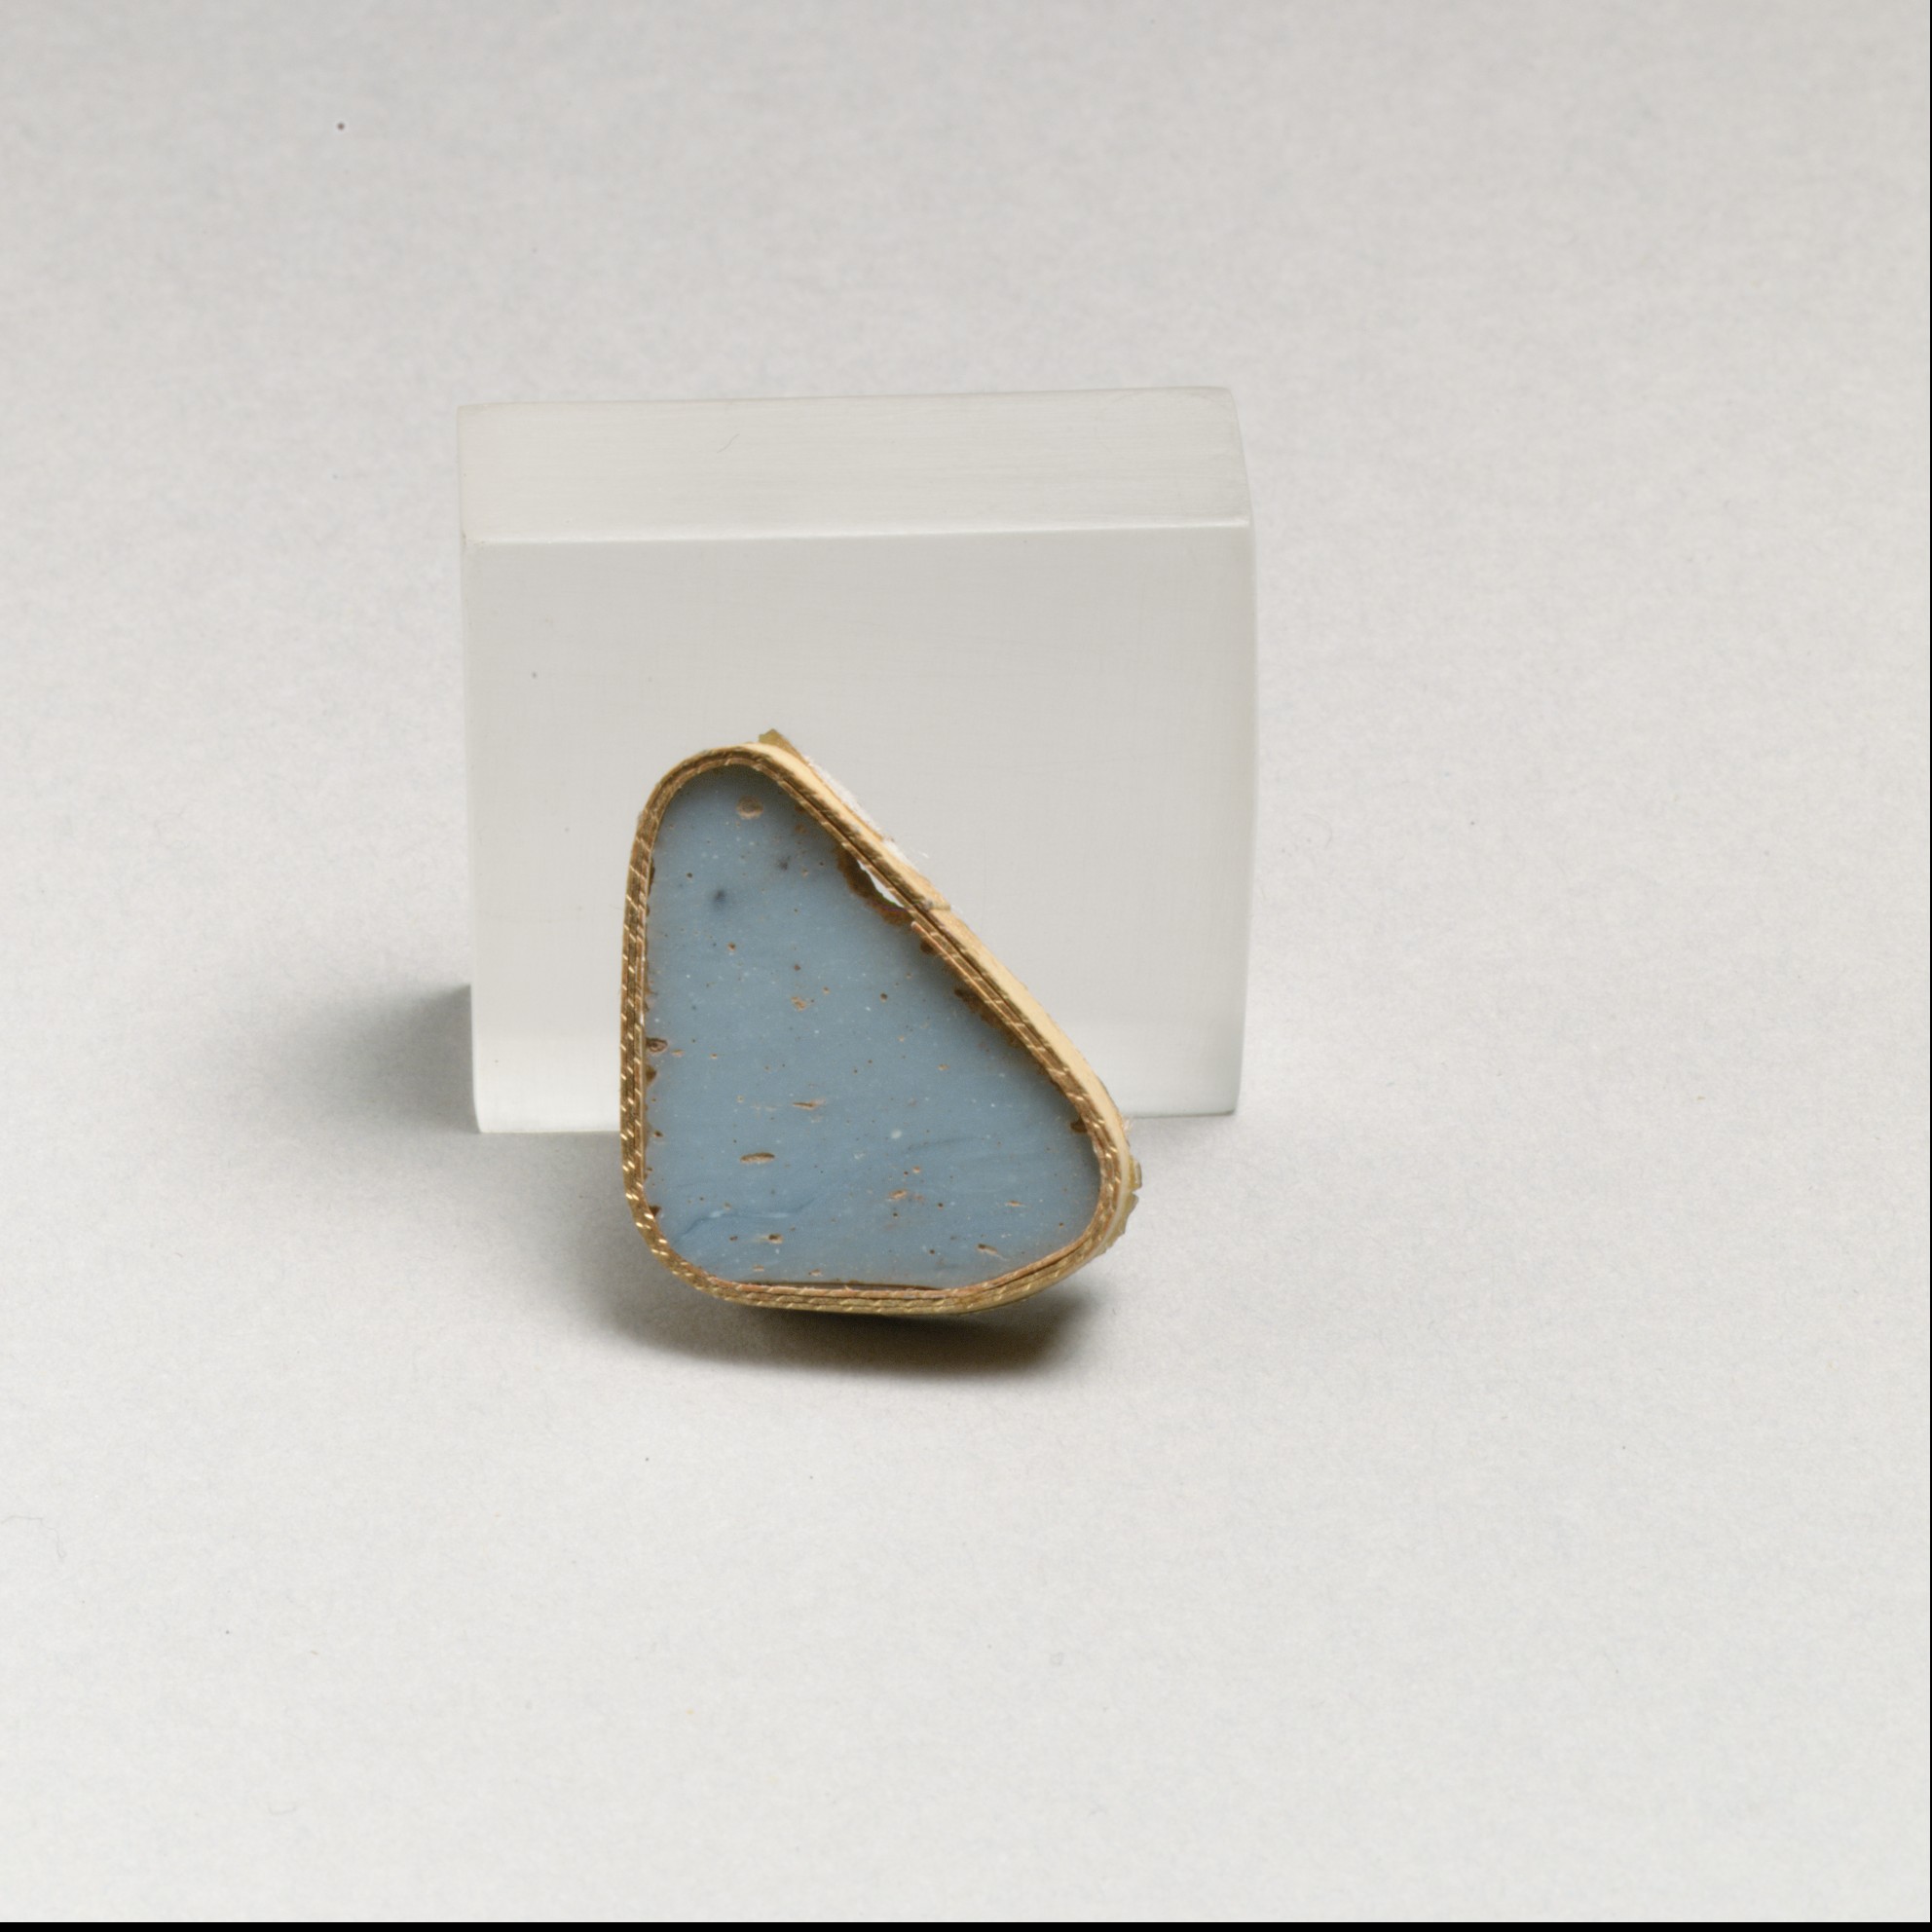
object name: inlay, monochrome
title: Glass monochrome inlay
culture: roman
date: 1-50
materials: glass